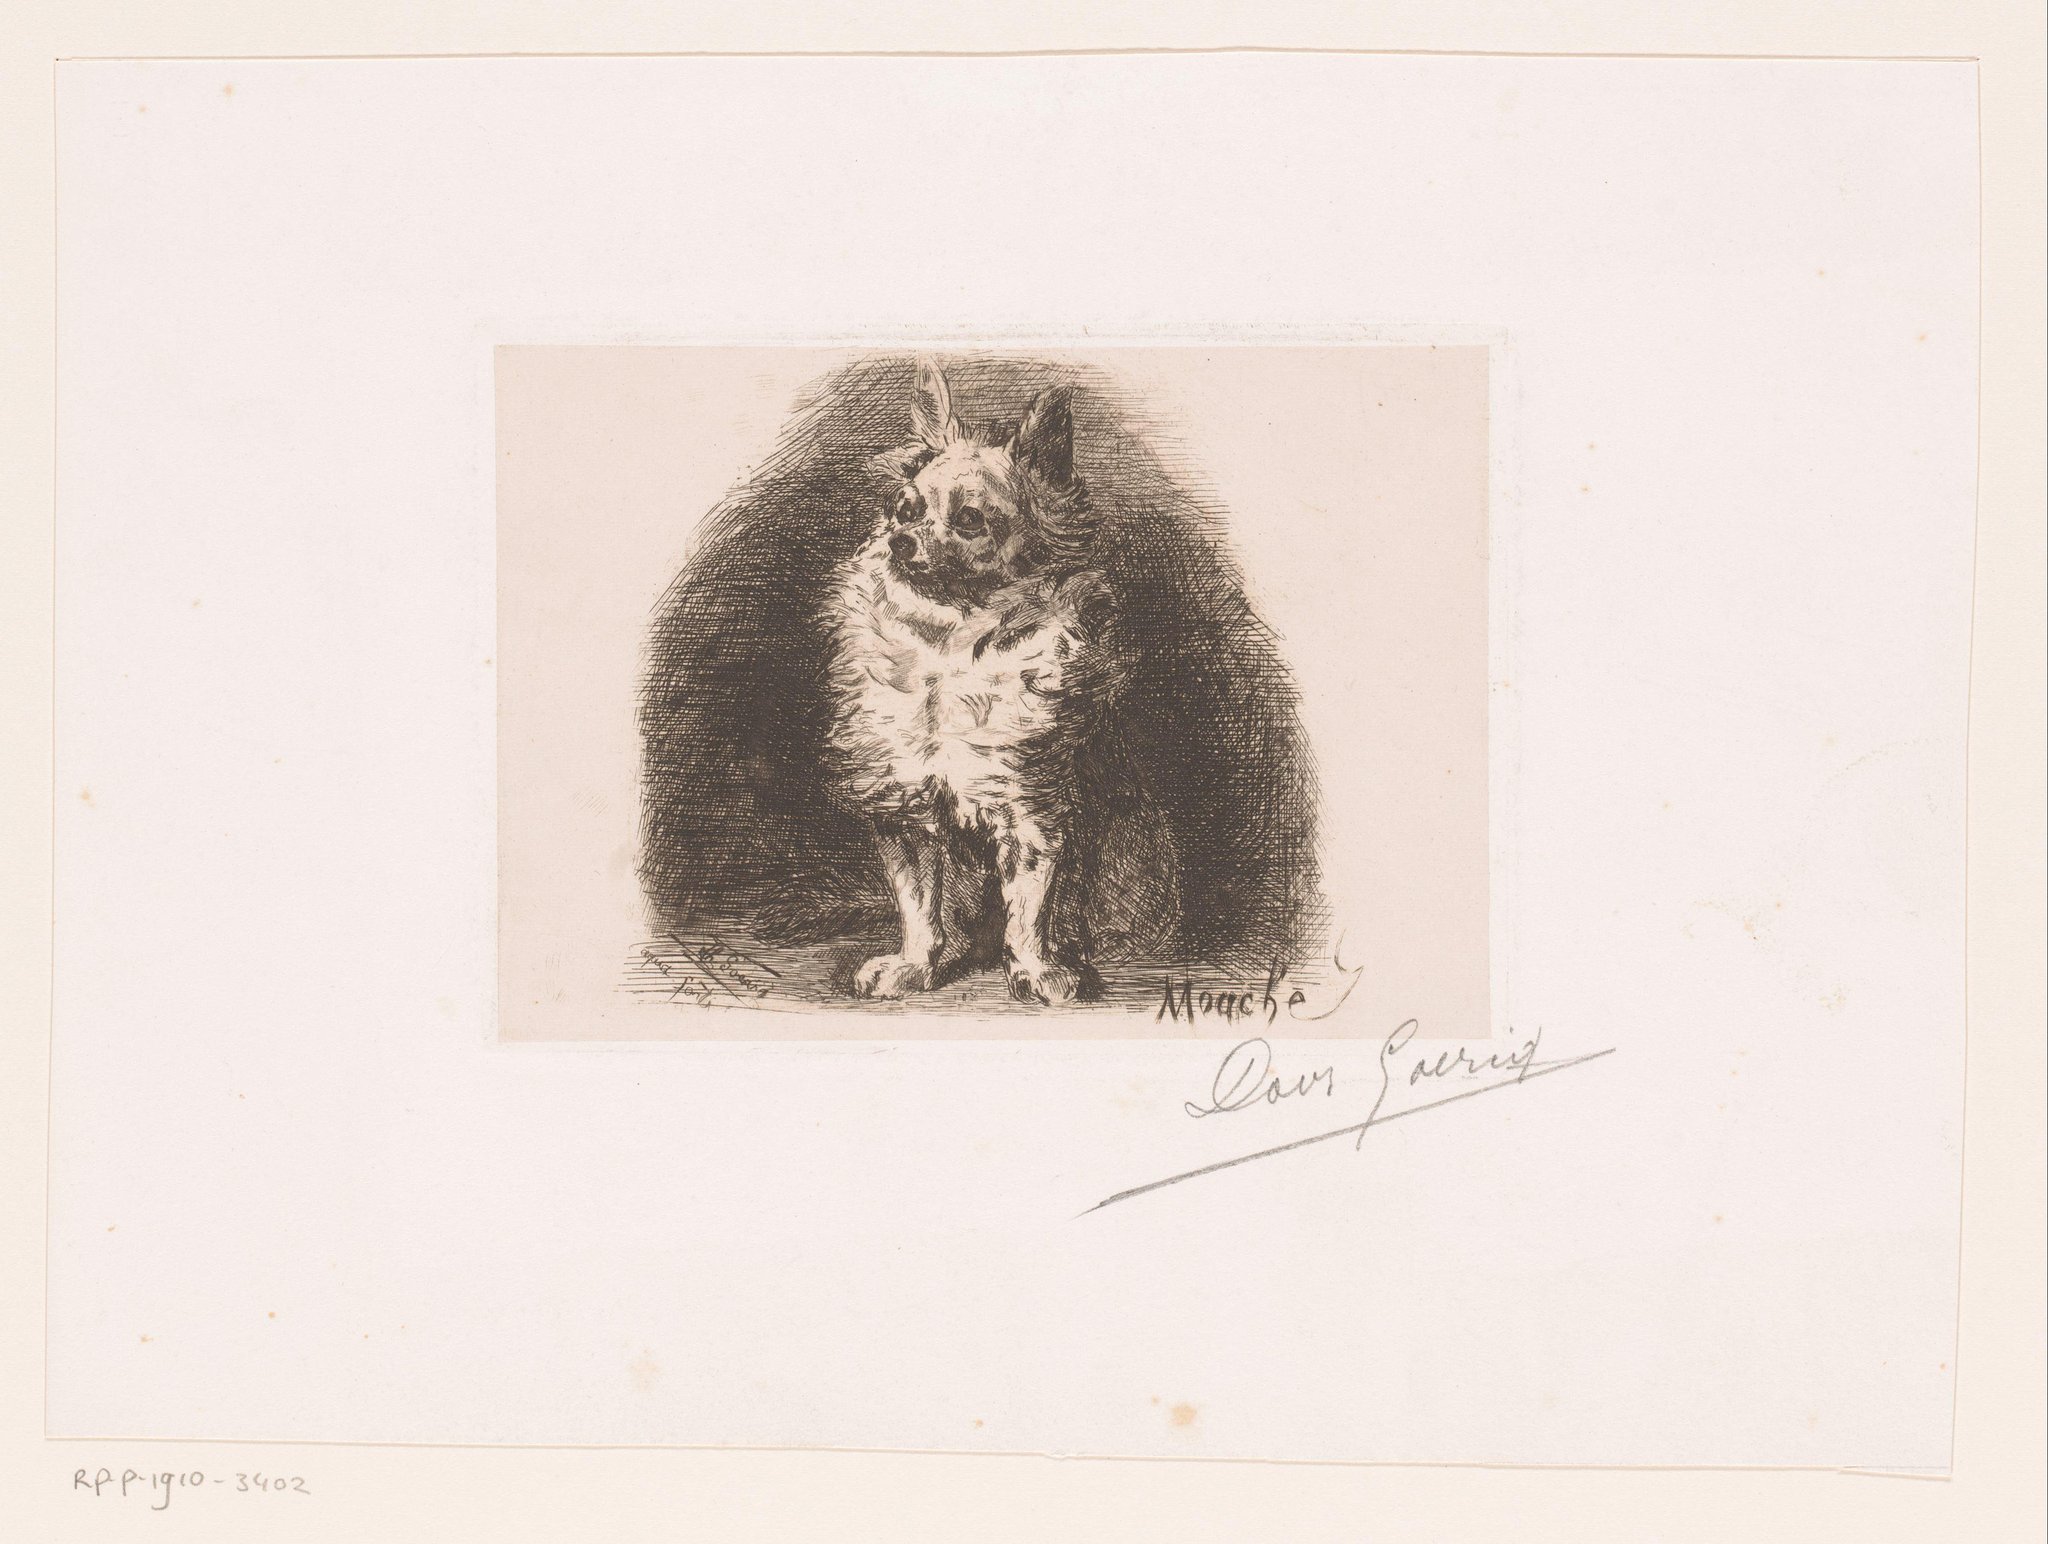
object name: print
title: Hond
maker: david goerig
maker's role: print maker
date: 1850-1899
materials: paper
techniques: etching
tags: dog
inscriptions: collector's mark: Lugt 2228